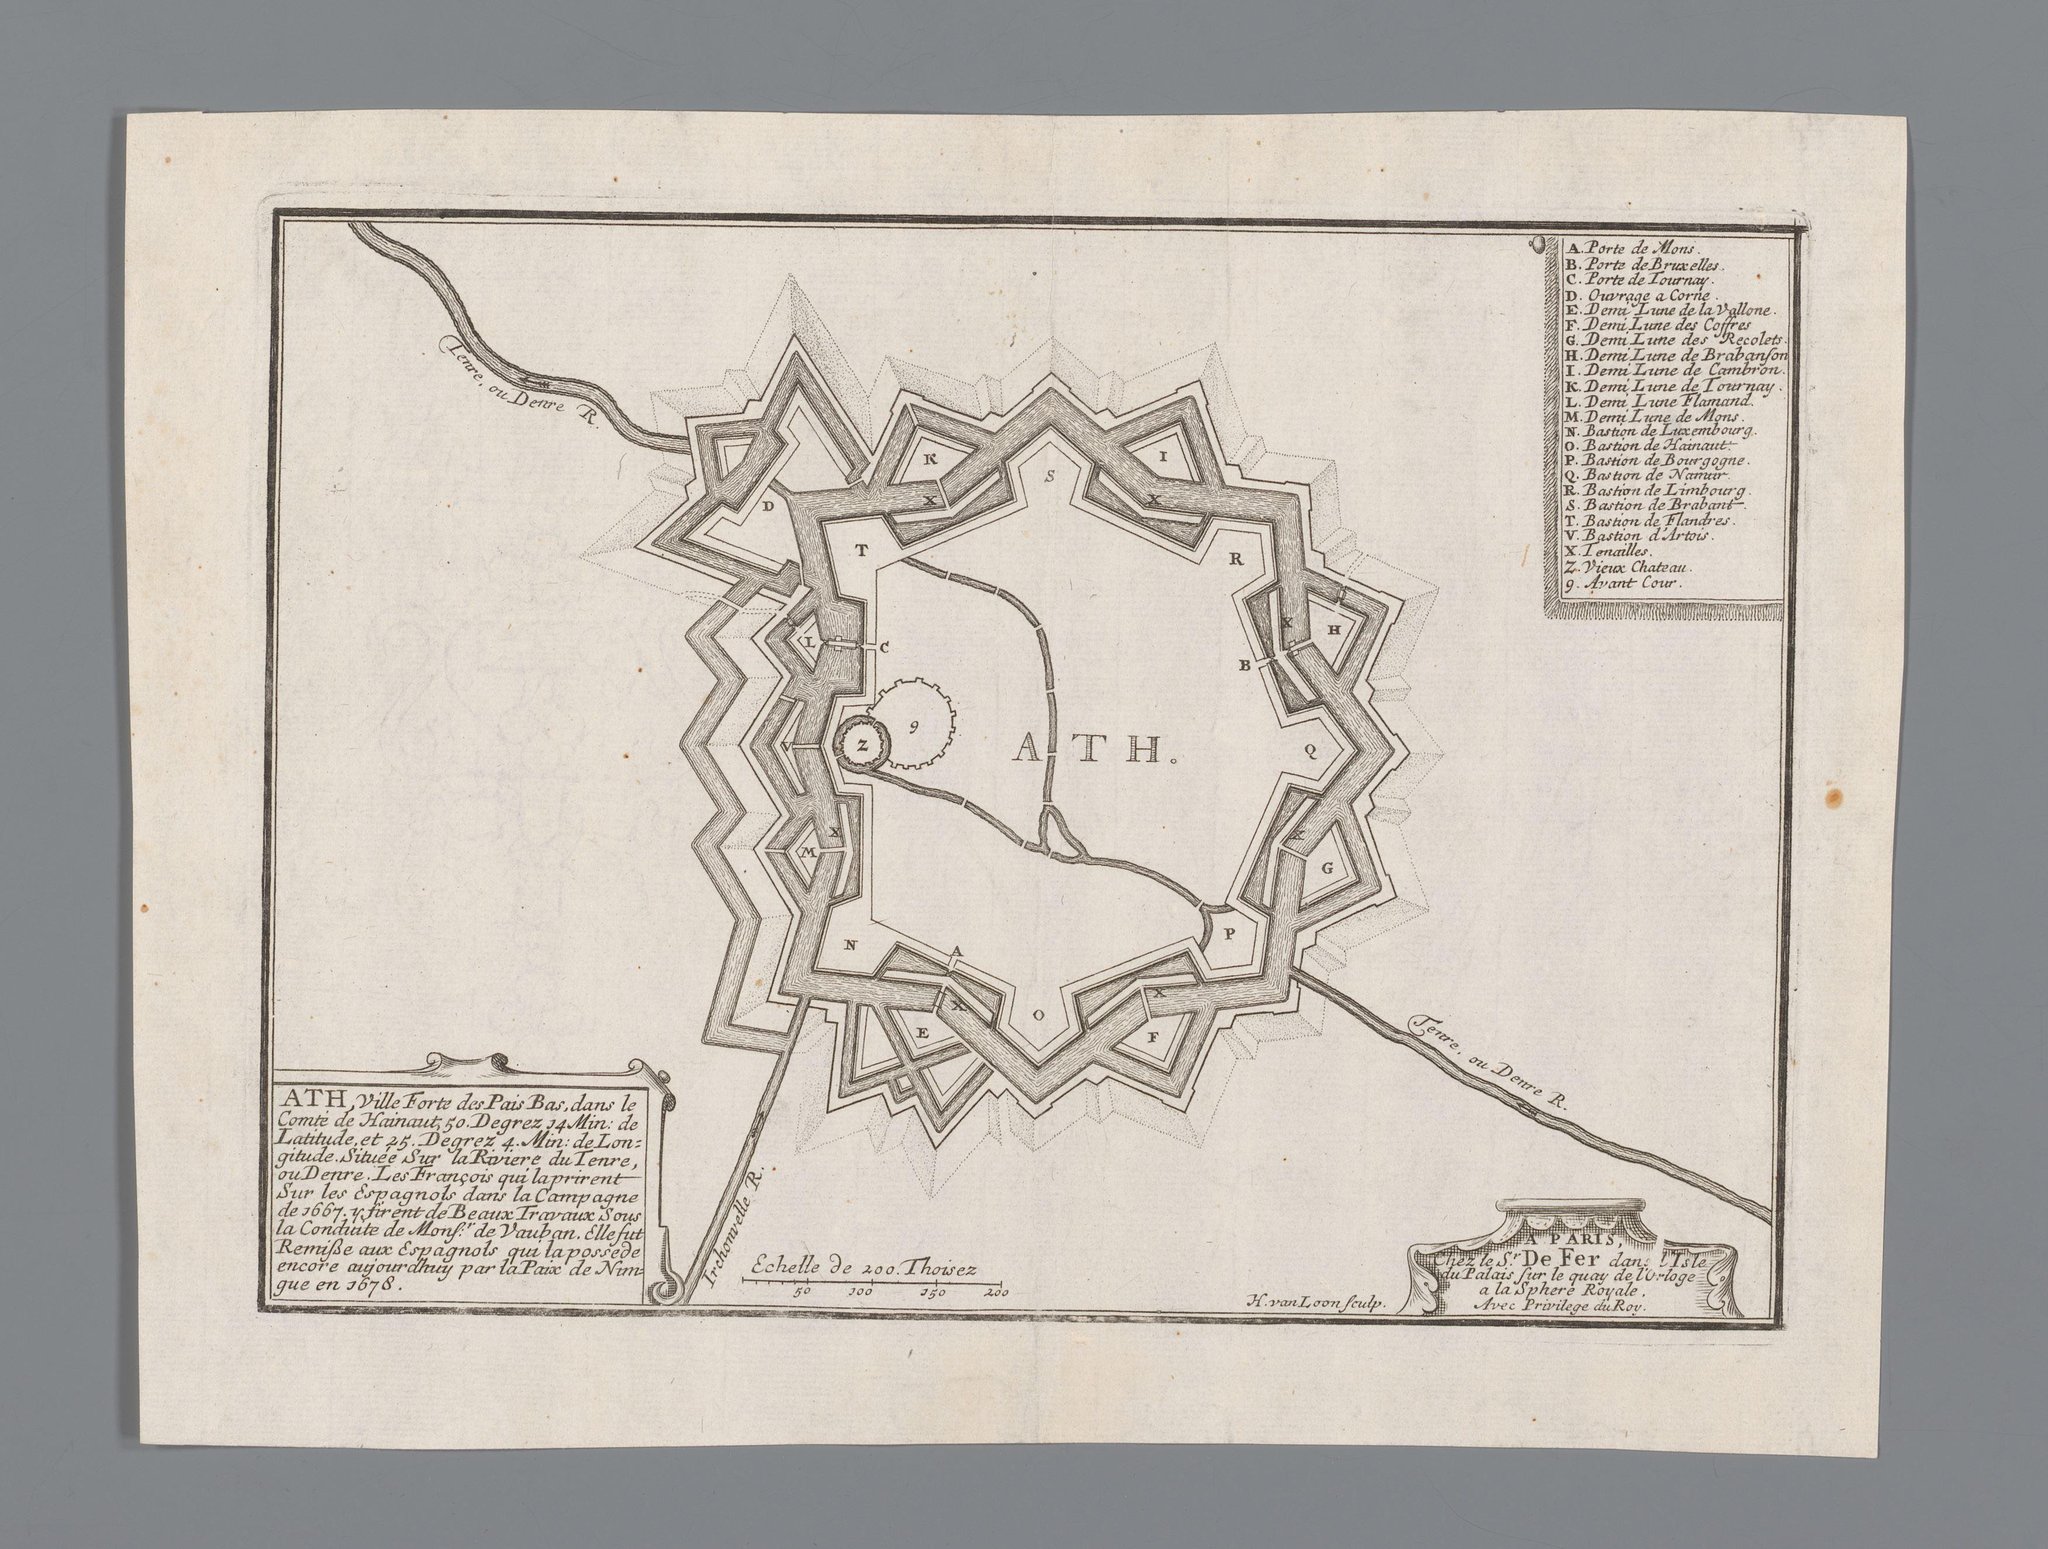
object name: print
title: Plattegrond van de fortificaties rond de stad Ath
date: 1693-1697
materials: paper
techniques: etching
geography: paris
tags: fortress, maps of cities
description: Prent uit: Les Forces de l'Europe, Asie, Afrique et Amerique (...) Comme aussi les Cartes des Côtes de France et d'Espagne. Parijs: Nicolas de Fer, 1693-1697. Het prentwerk bestaat uit 175 platen met plannen (onder andere afkomstig van Sébastien Le Prestre, Seigneur de Vauban) van vermaarde sterke steden en vestingen in de Negenjarige Oorlog.